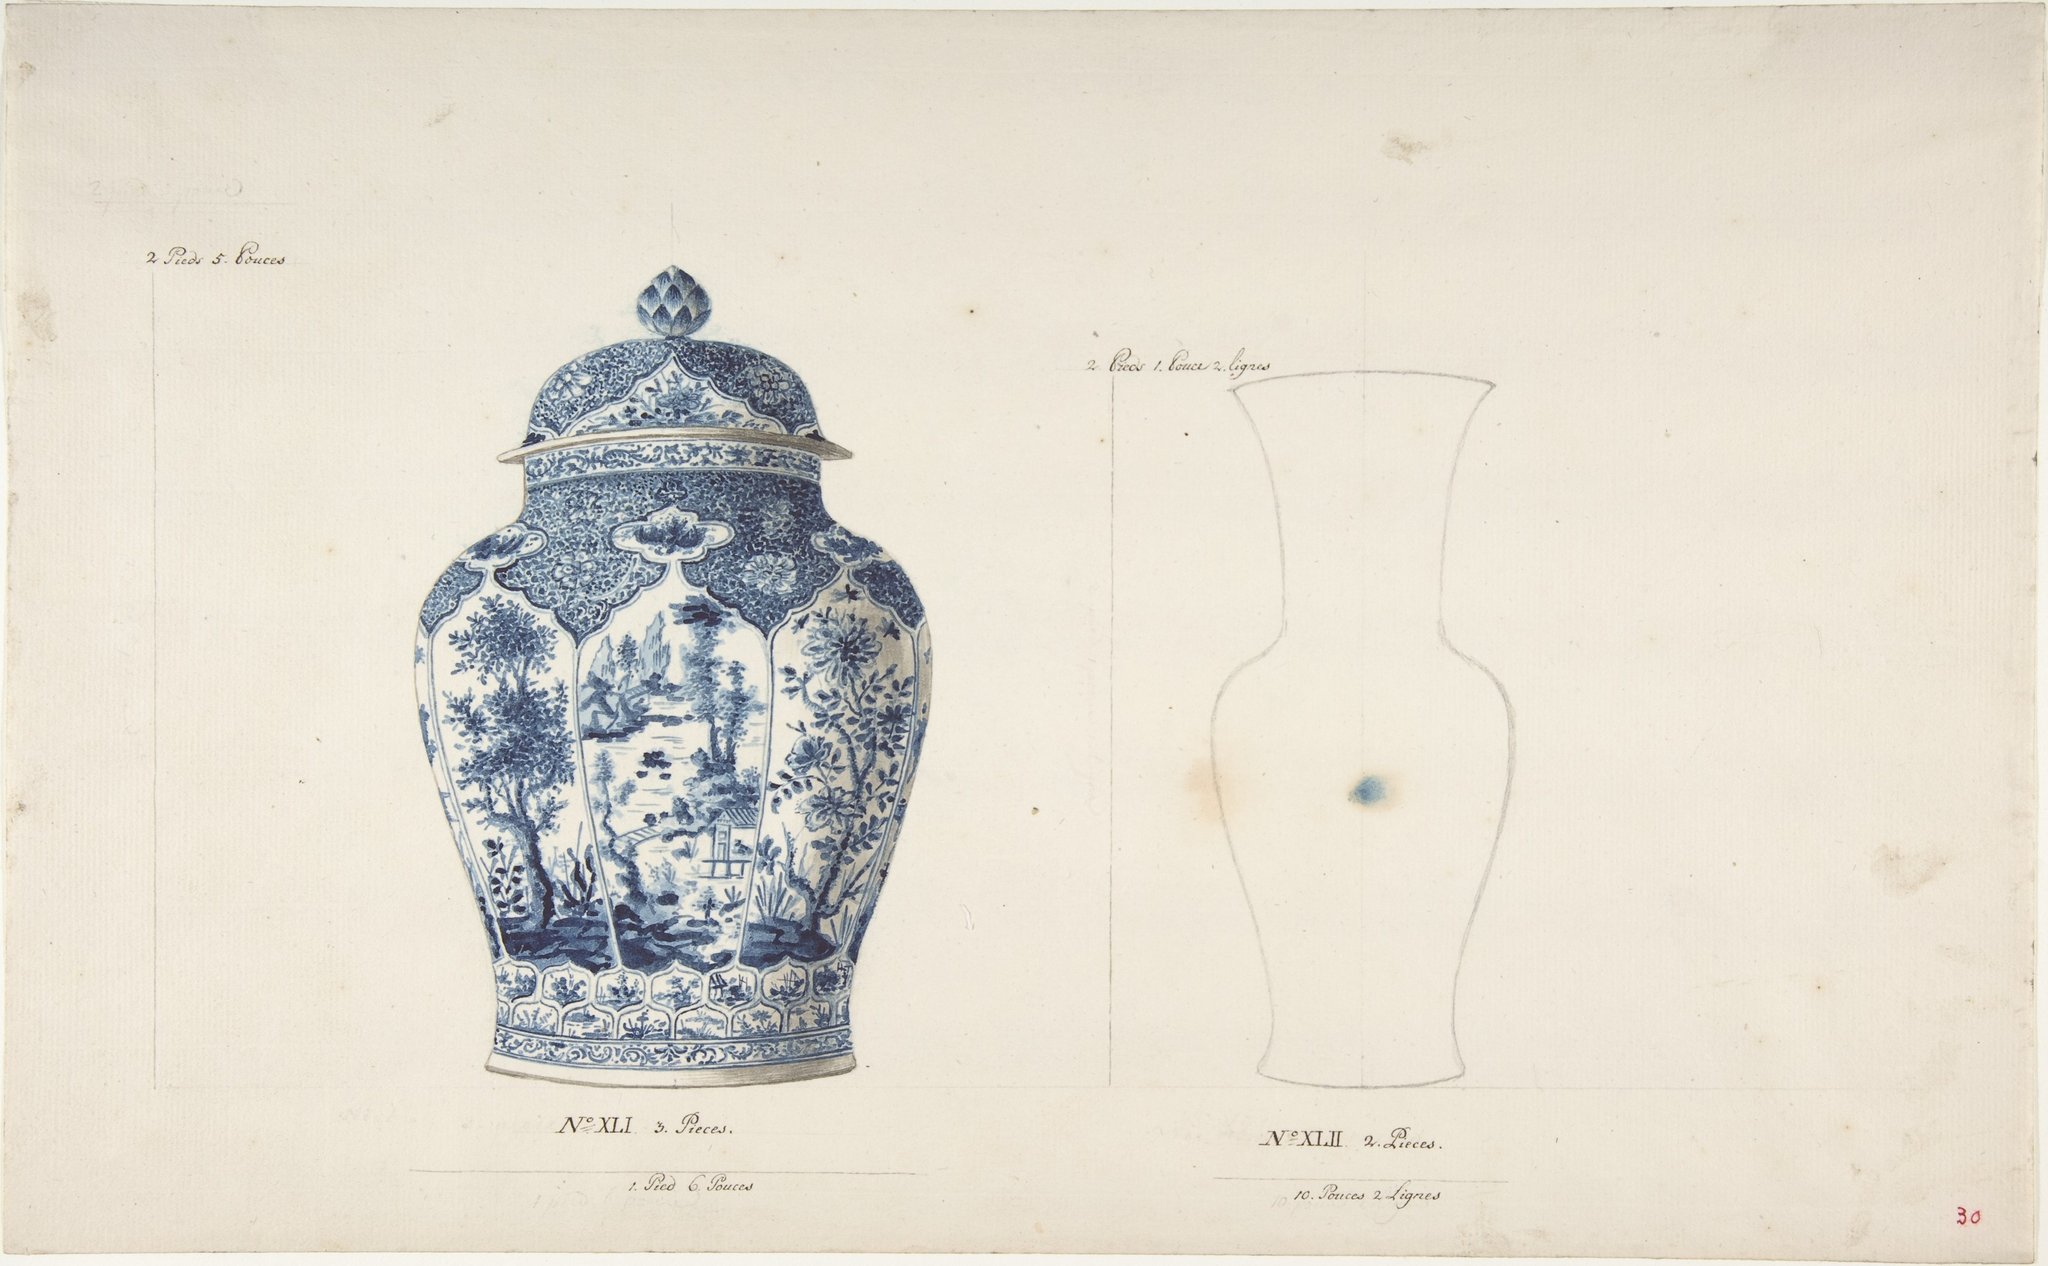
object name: drawing ornament architecture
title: Design for Two Vases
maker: anonymous, french, 18th century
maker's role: artist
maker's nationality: french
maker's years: 1700-1800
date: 1770-1785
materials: chalk, ink, watercolor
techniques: pen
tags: trees,vases